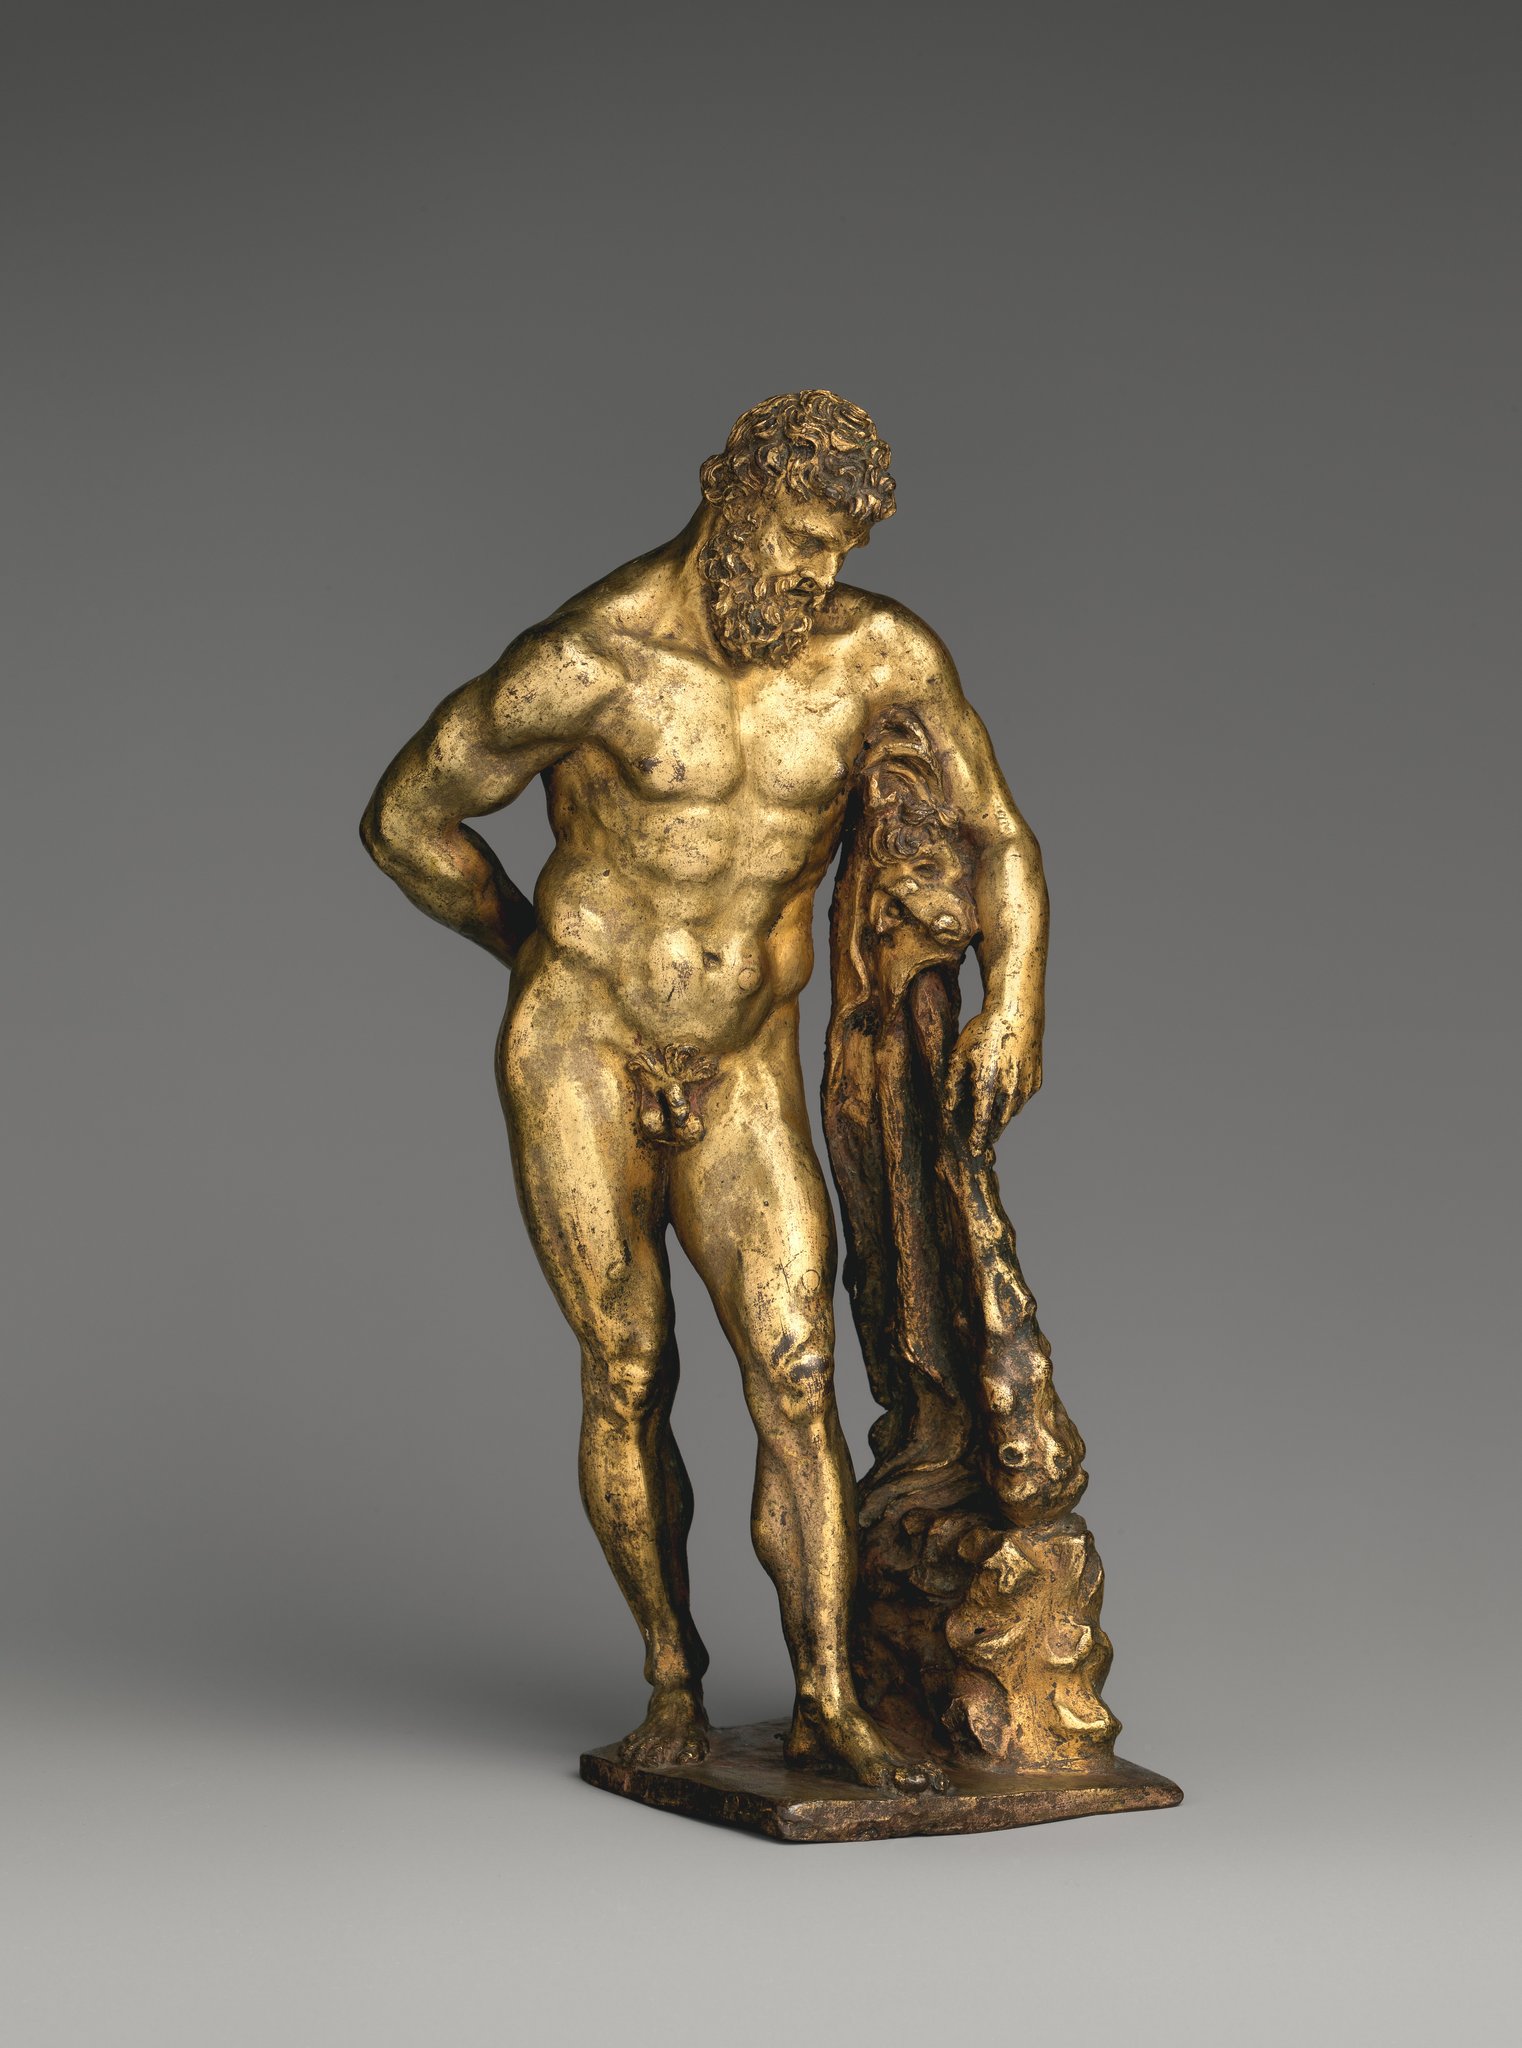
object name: statuette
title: Farnese Hercules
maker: pietro da barga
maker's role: modeler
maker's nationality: italian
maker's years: 1574-1588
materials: bronze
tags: male nudes,hercules